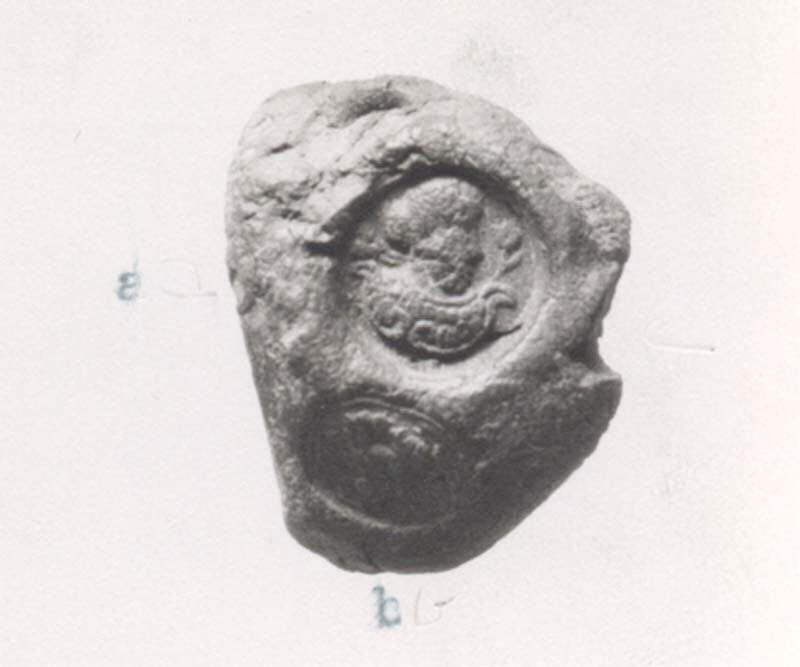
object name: sealing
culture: sasanian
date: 601-700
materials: clay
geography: iran